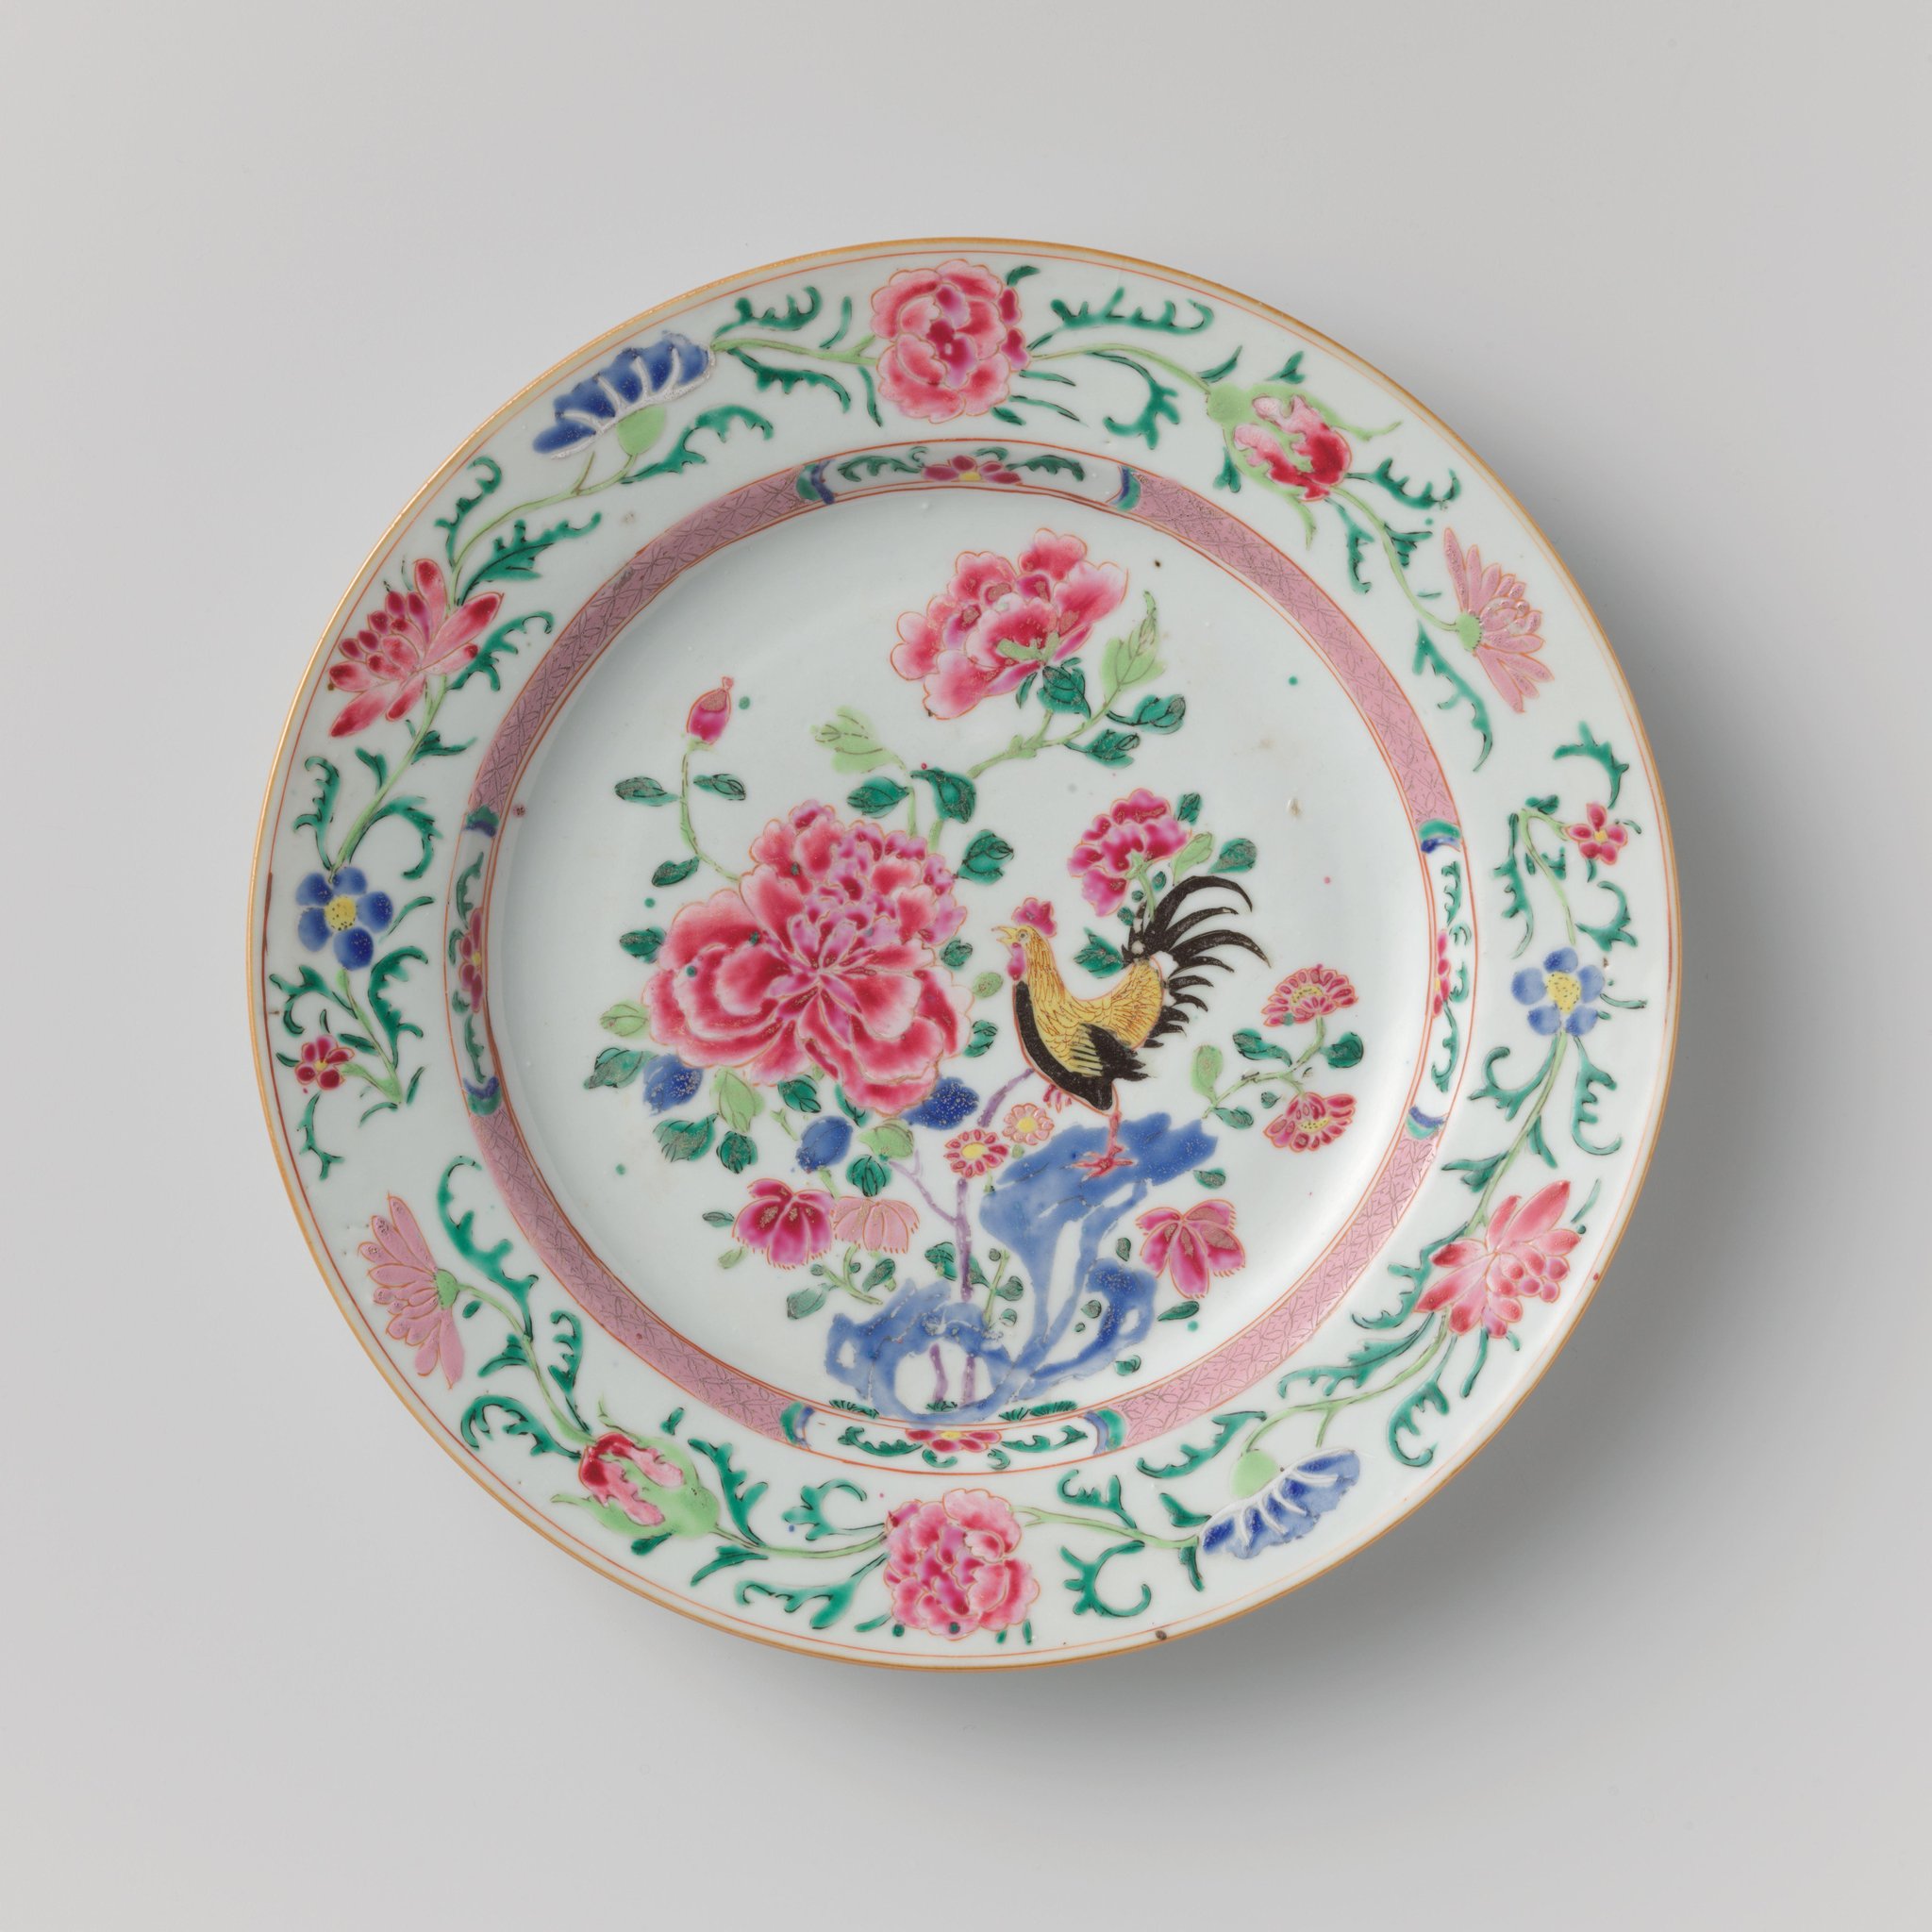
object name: plate dish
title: Plate with a cock on a rock near flowering plants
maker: Anonymous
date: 1725-1749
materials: glaze, paint, porcelain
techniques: firing, turning, vitrification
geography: china